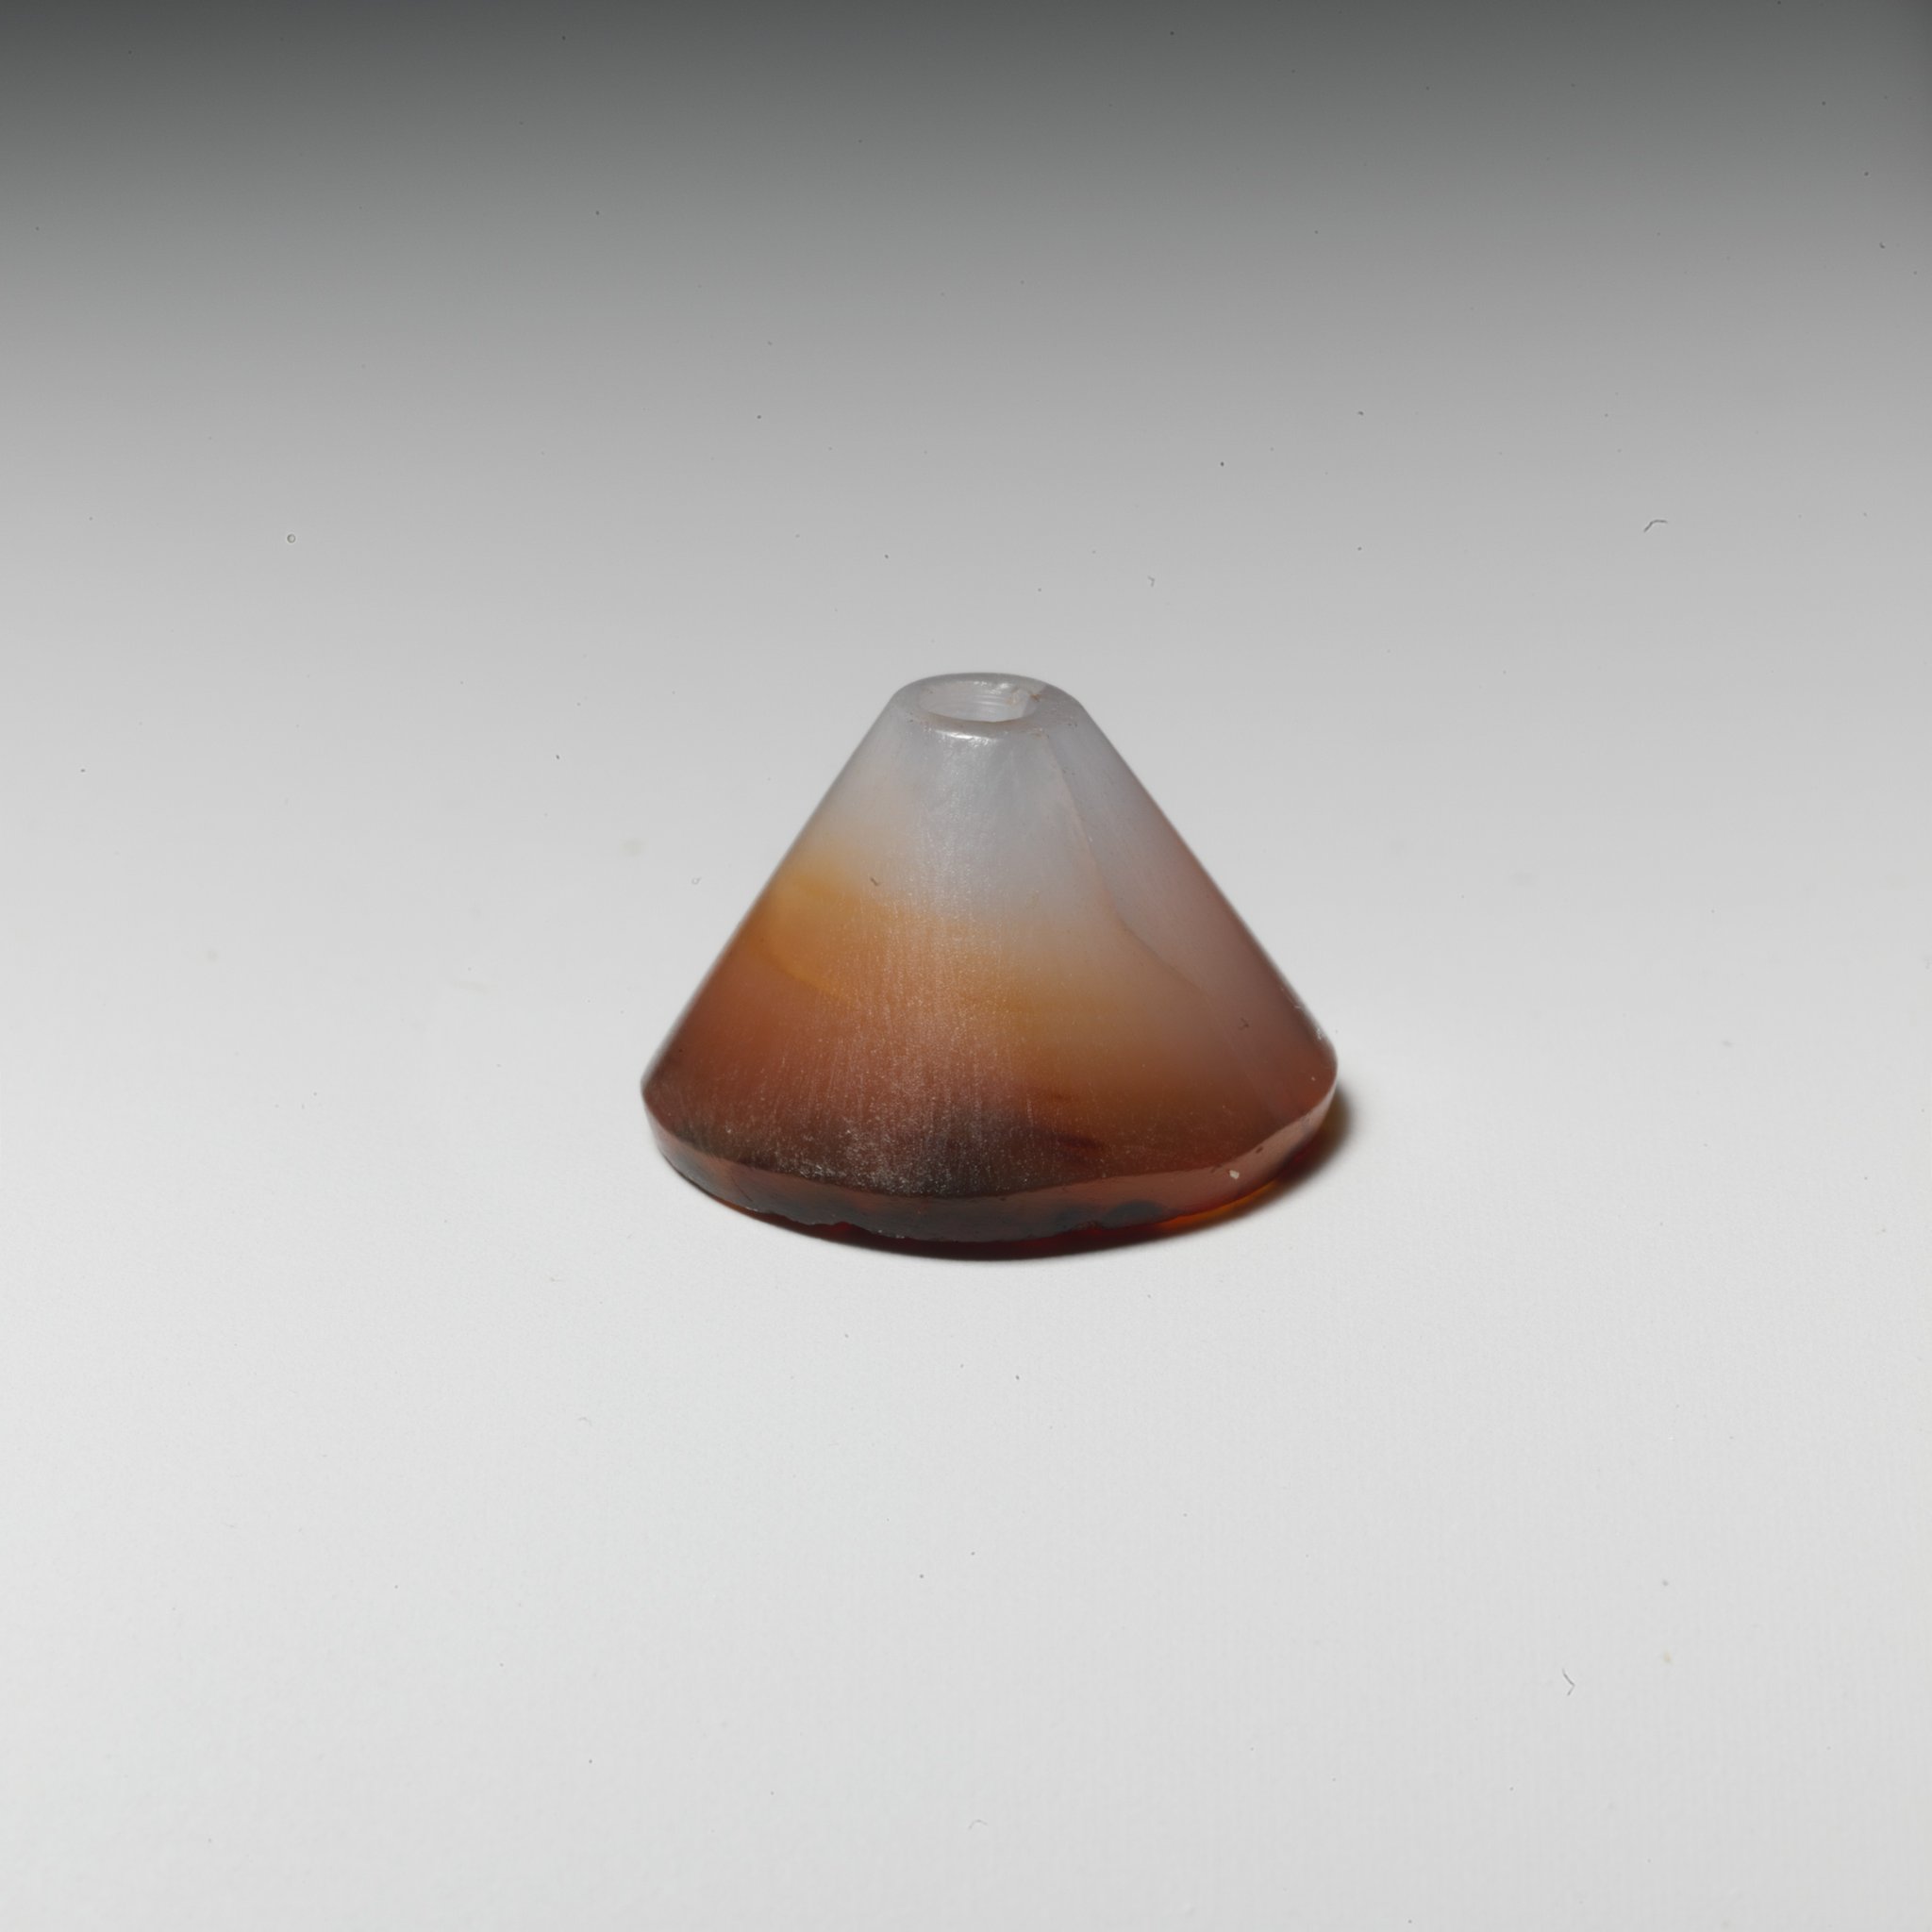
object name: spindle whorl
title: Agate spindle whorl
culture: minoan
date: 2200-1450 BCE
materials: stone